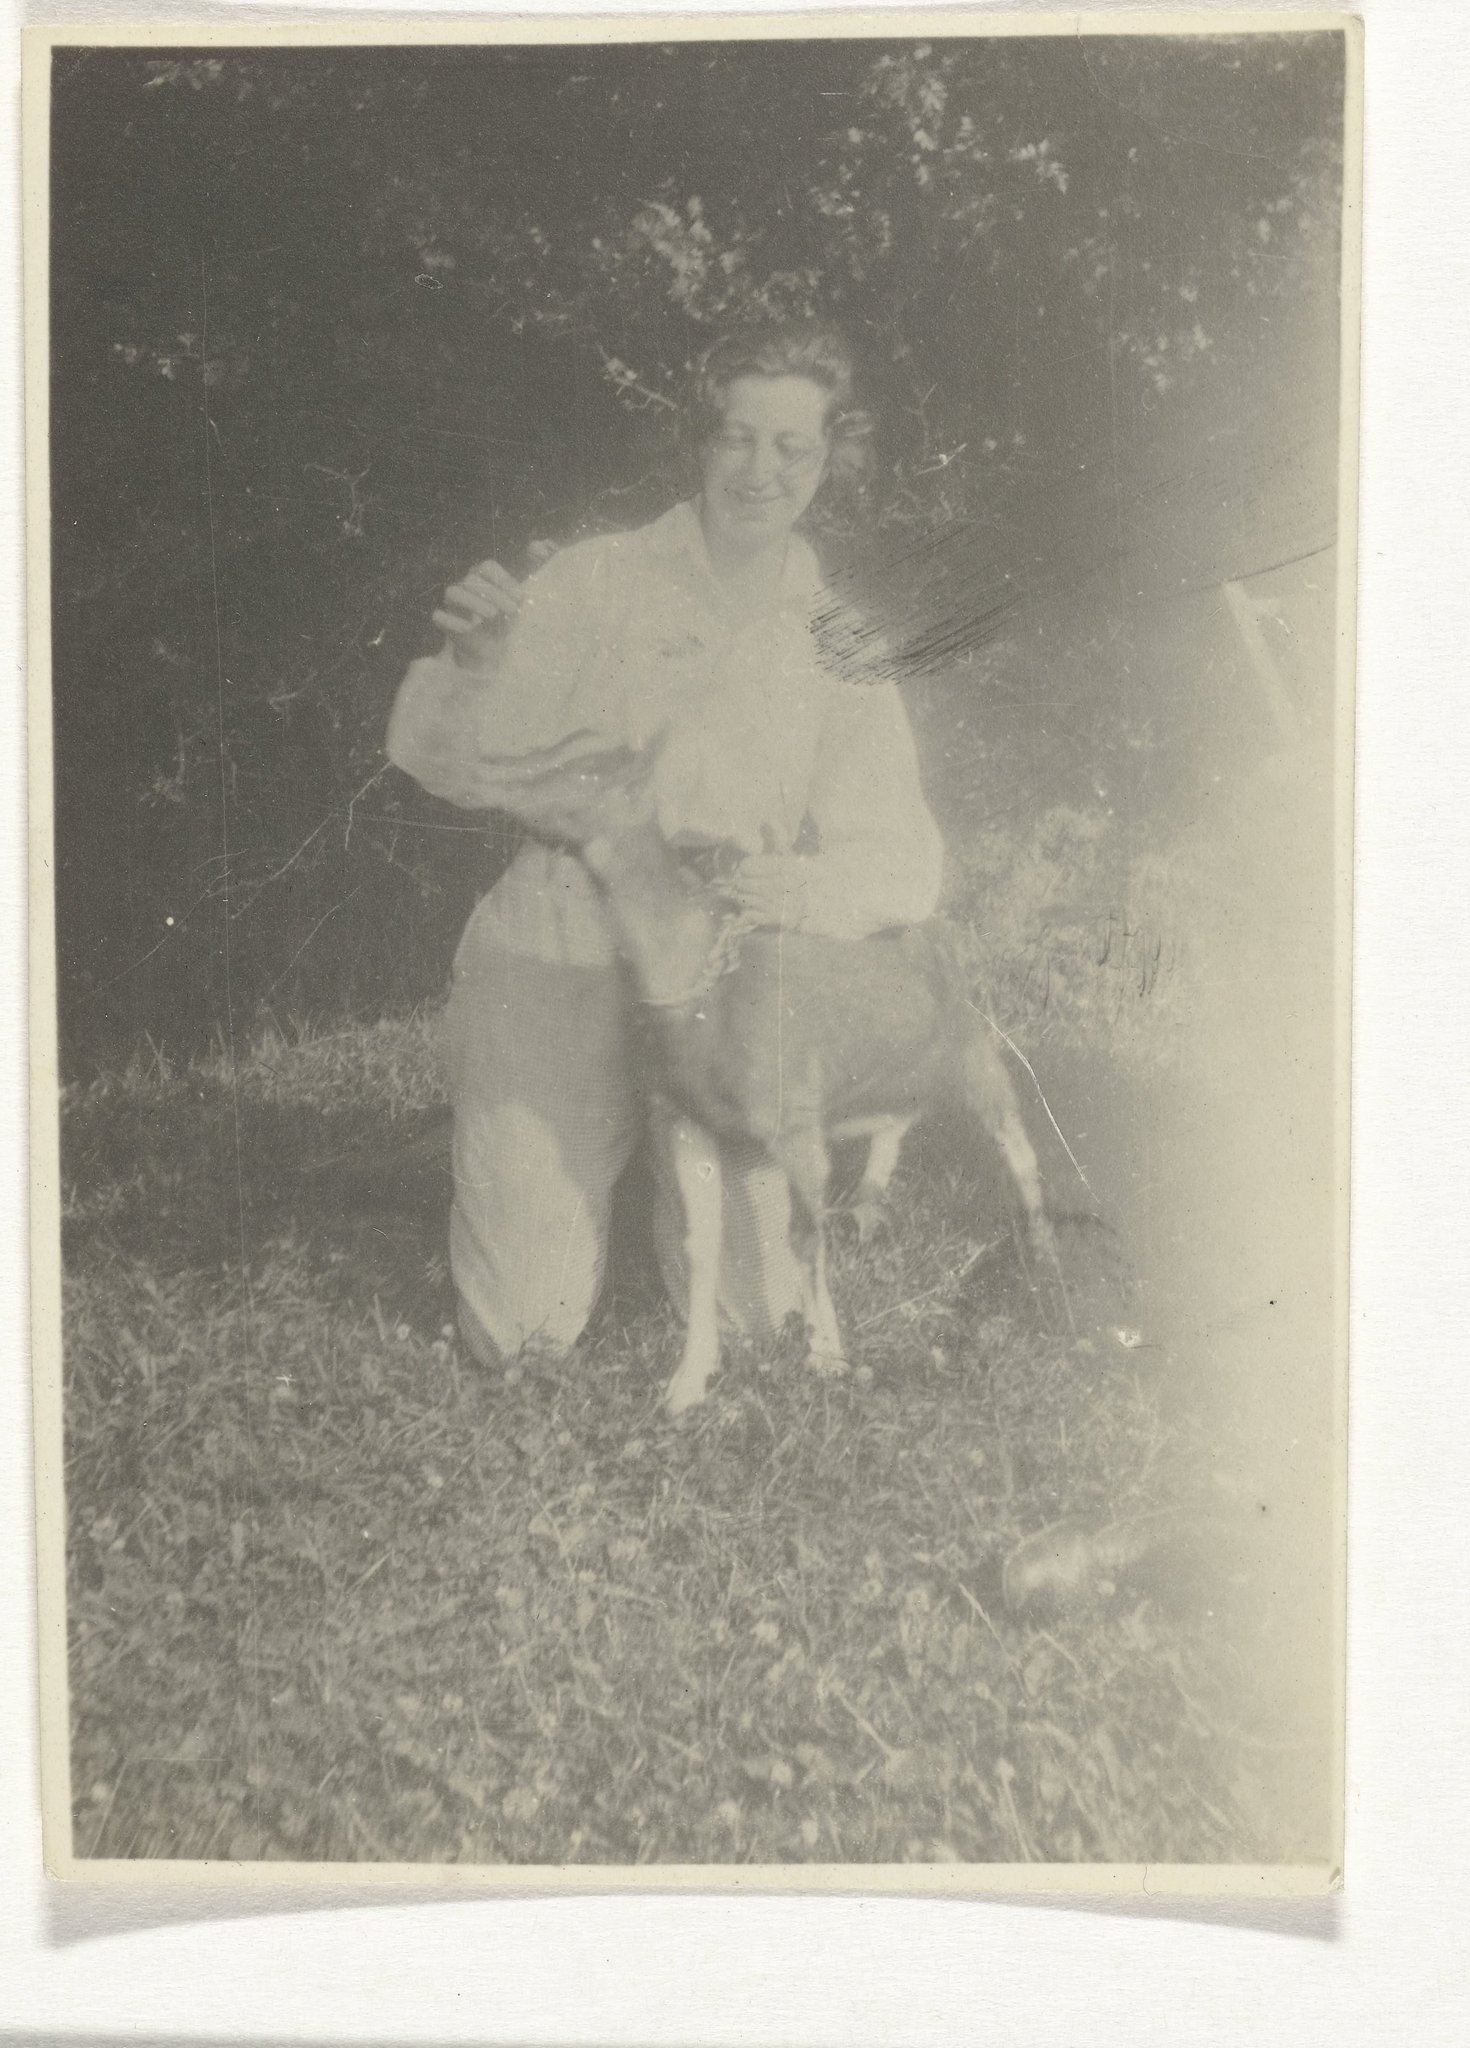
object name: photograph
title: Portret van Irene With met geit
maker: Anonymous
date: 1920-1935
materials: paper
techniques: gelatin silver print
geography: germany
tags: amsterdam, adult woman, historical persons, goat, germany